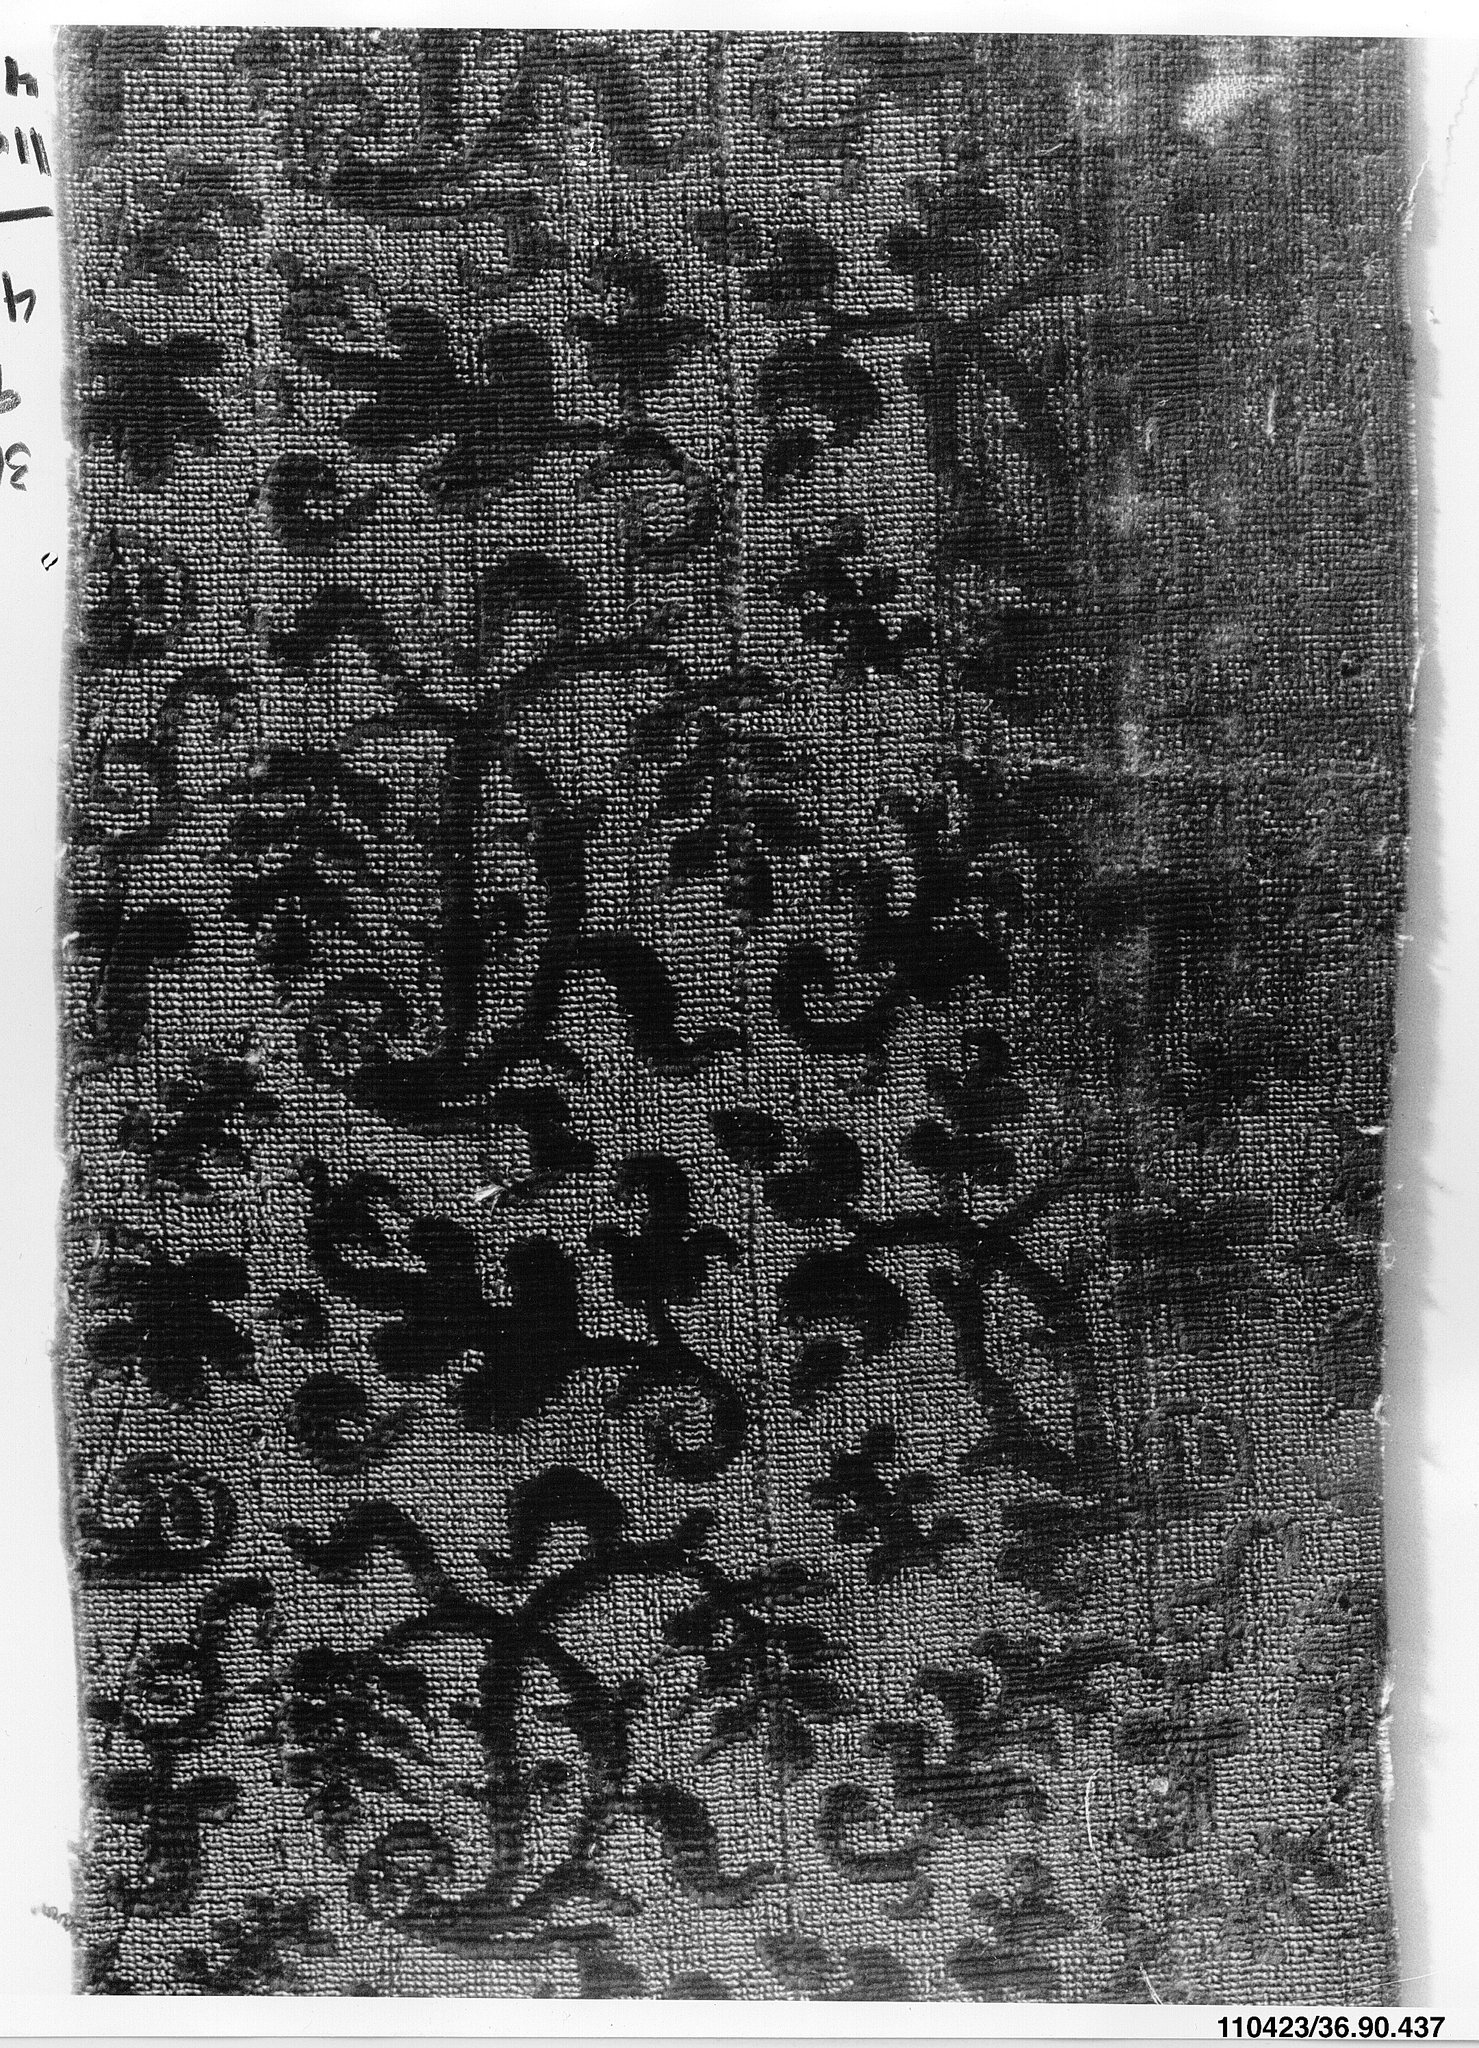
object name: piece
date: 1501-1700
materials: silk